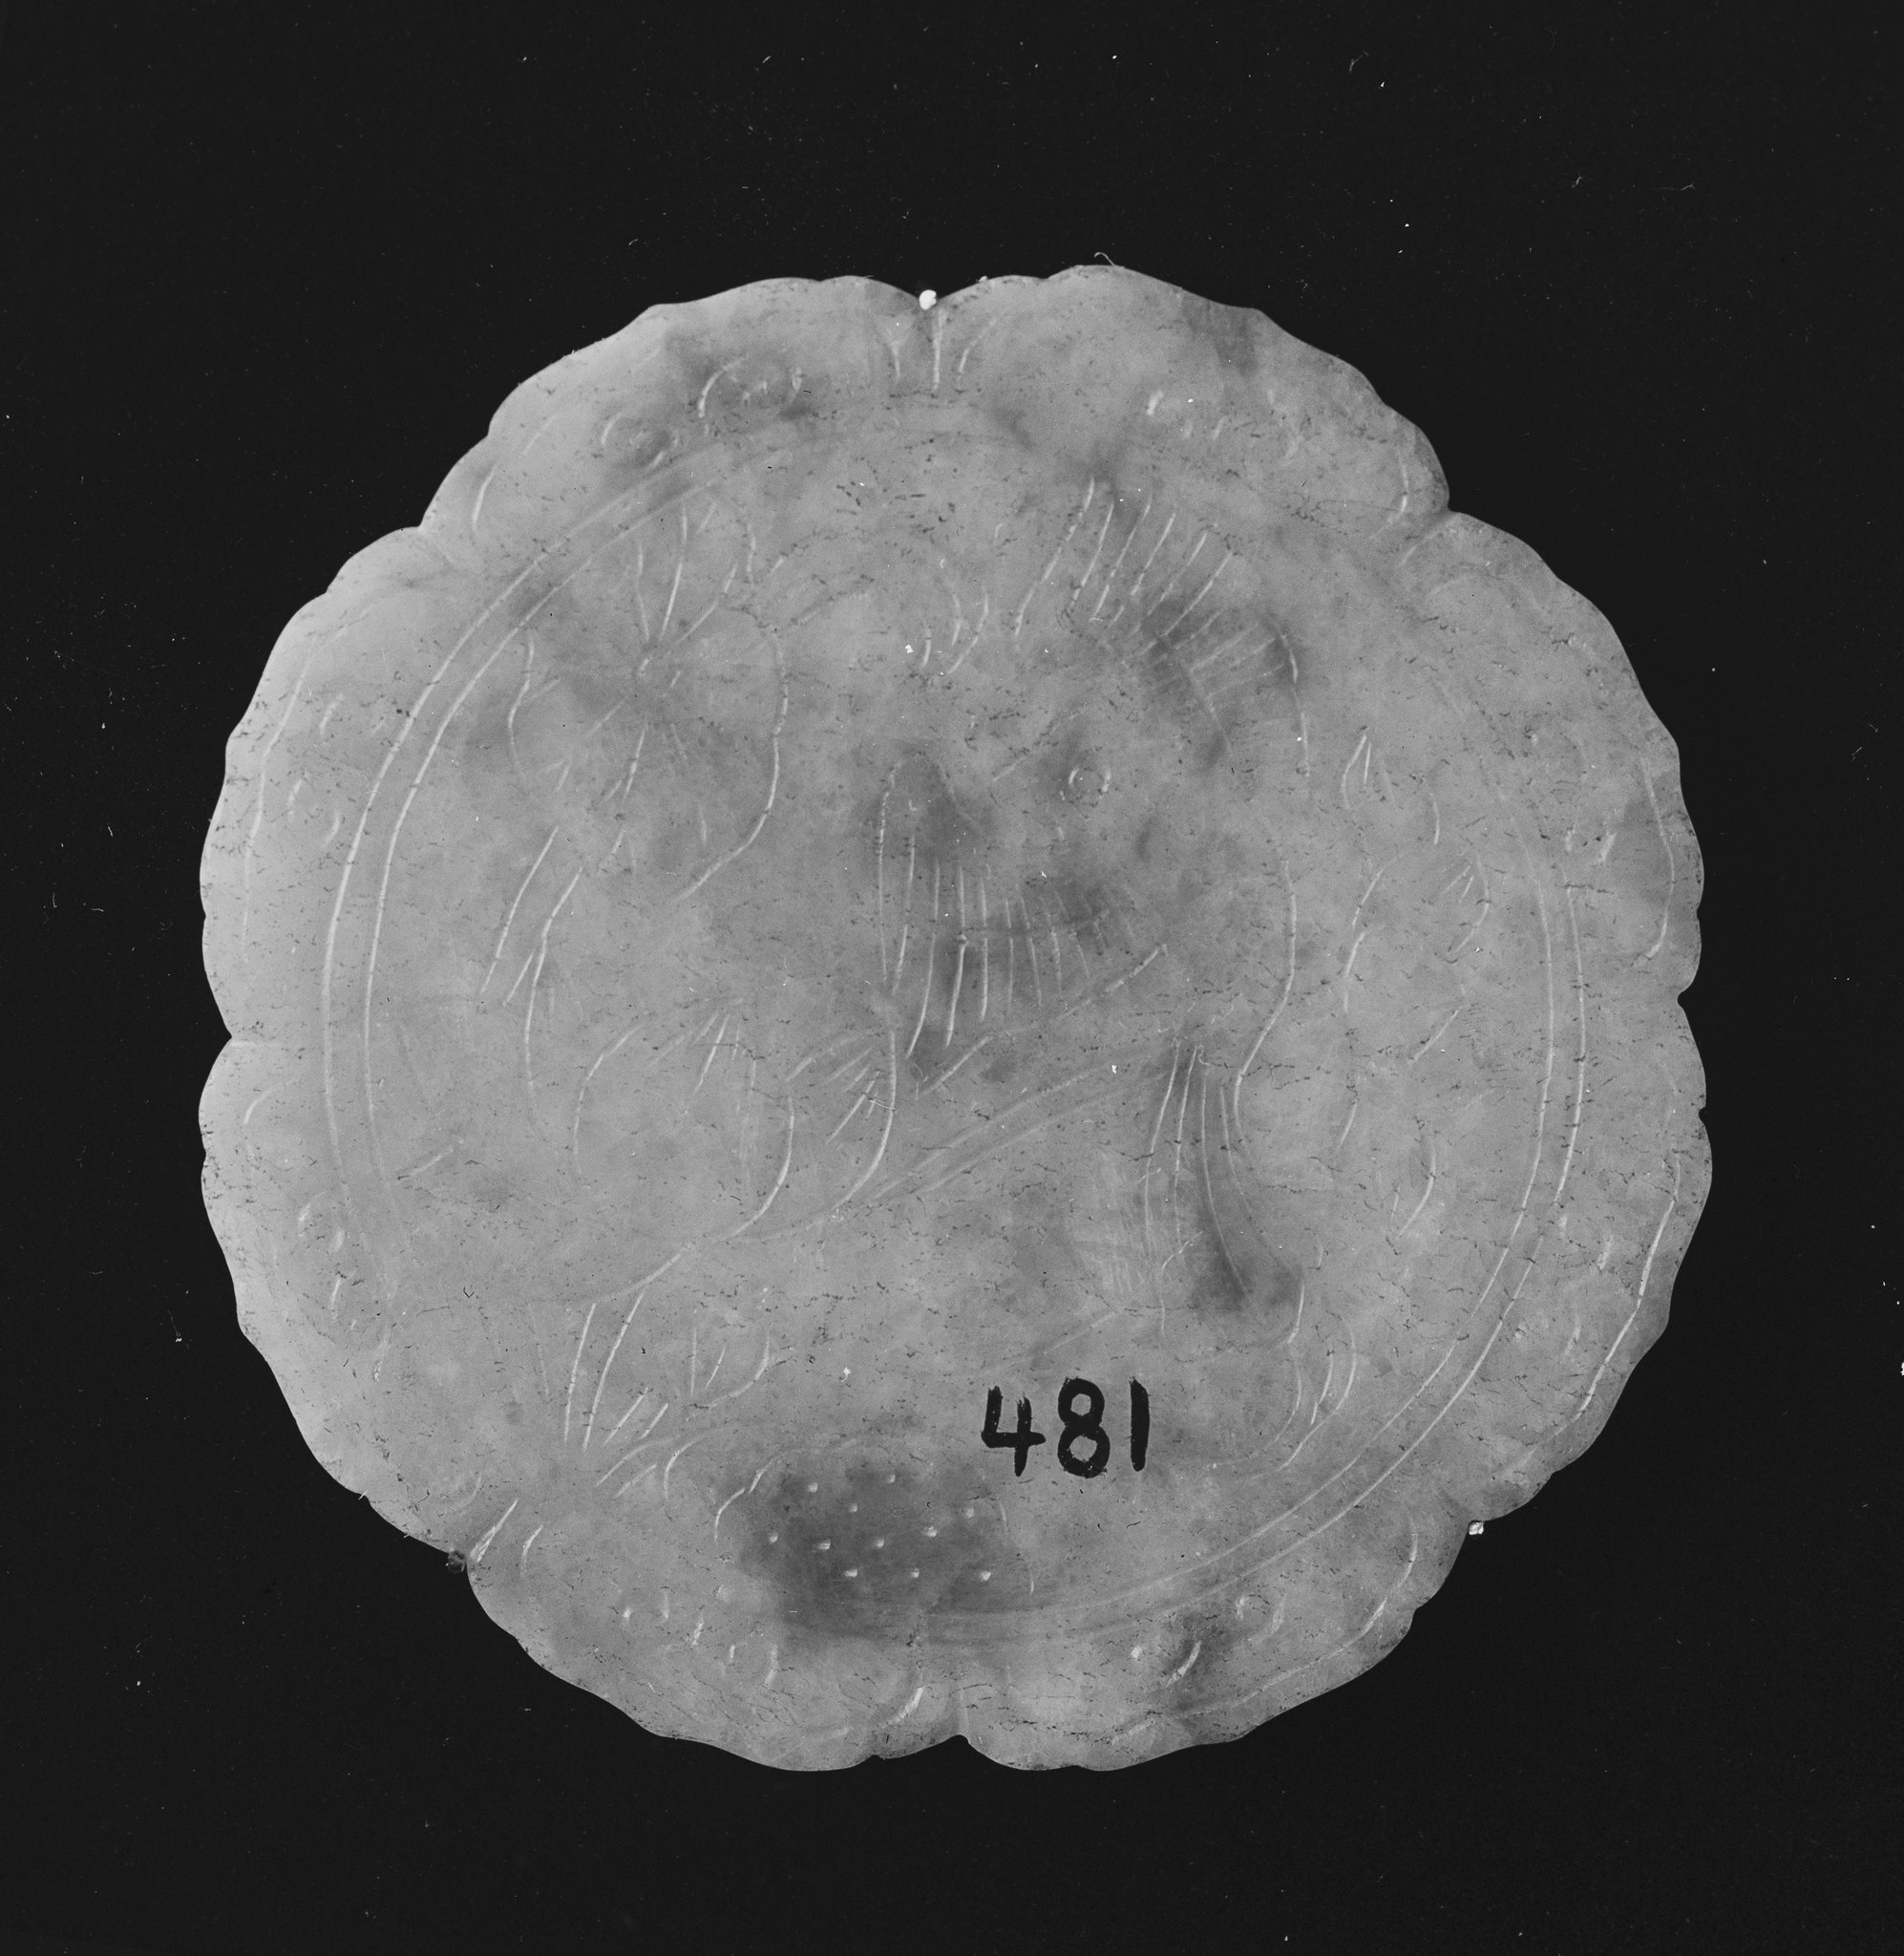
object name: medallion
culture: chinese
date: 1736-1795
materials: gemstone, jade